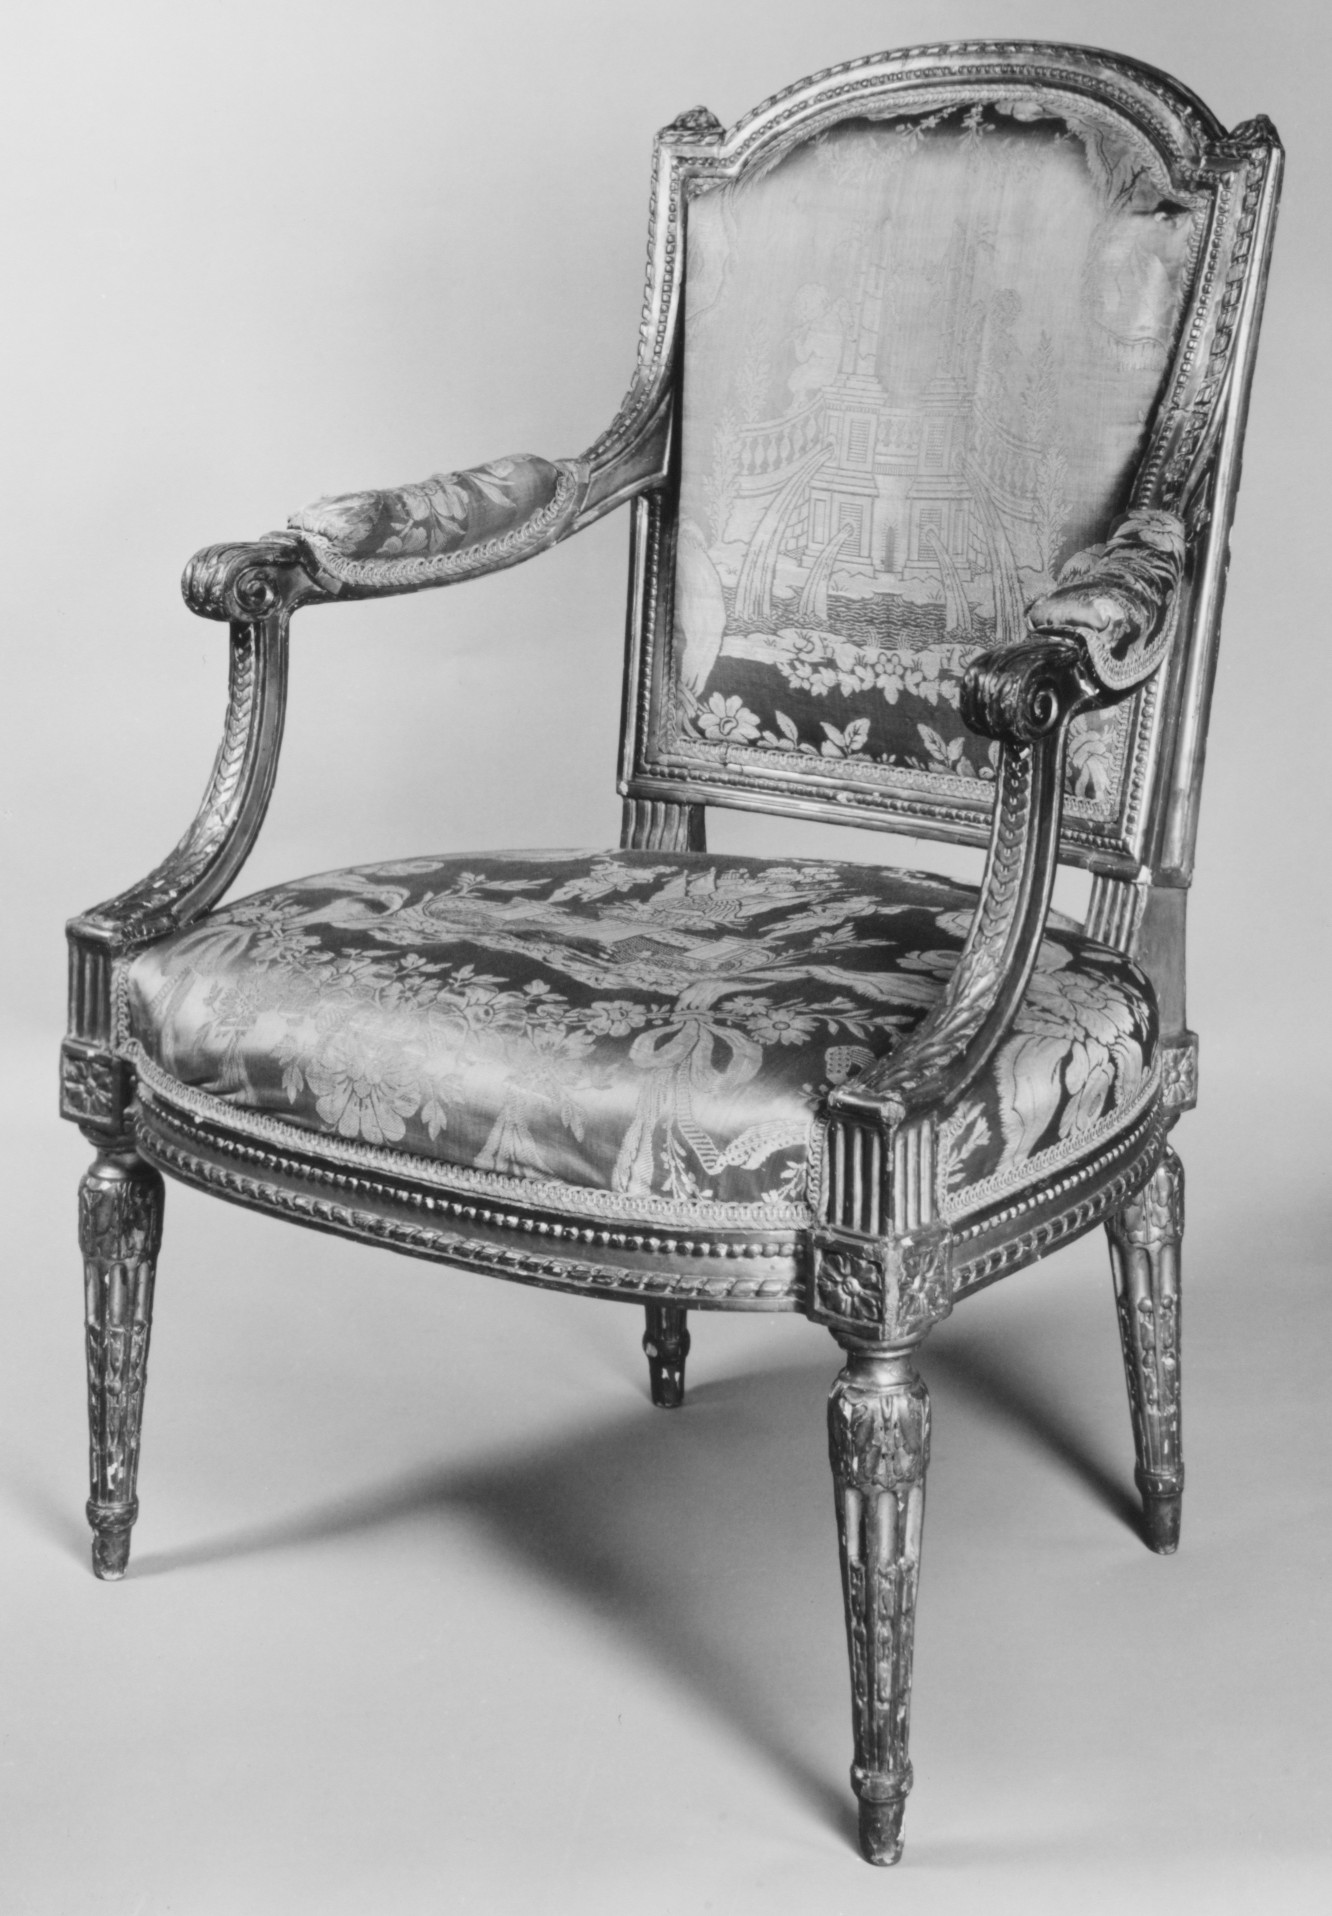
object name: armchair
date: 1780-1790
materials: wood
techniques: carving, gilding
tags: birds